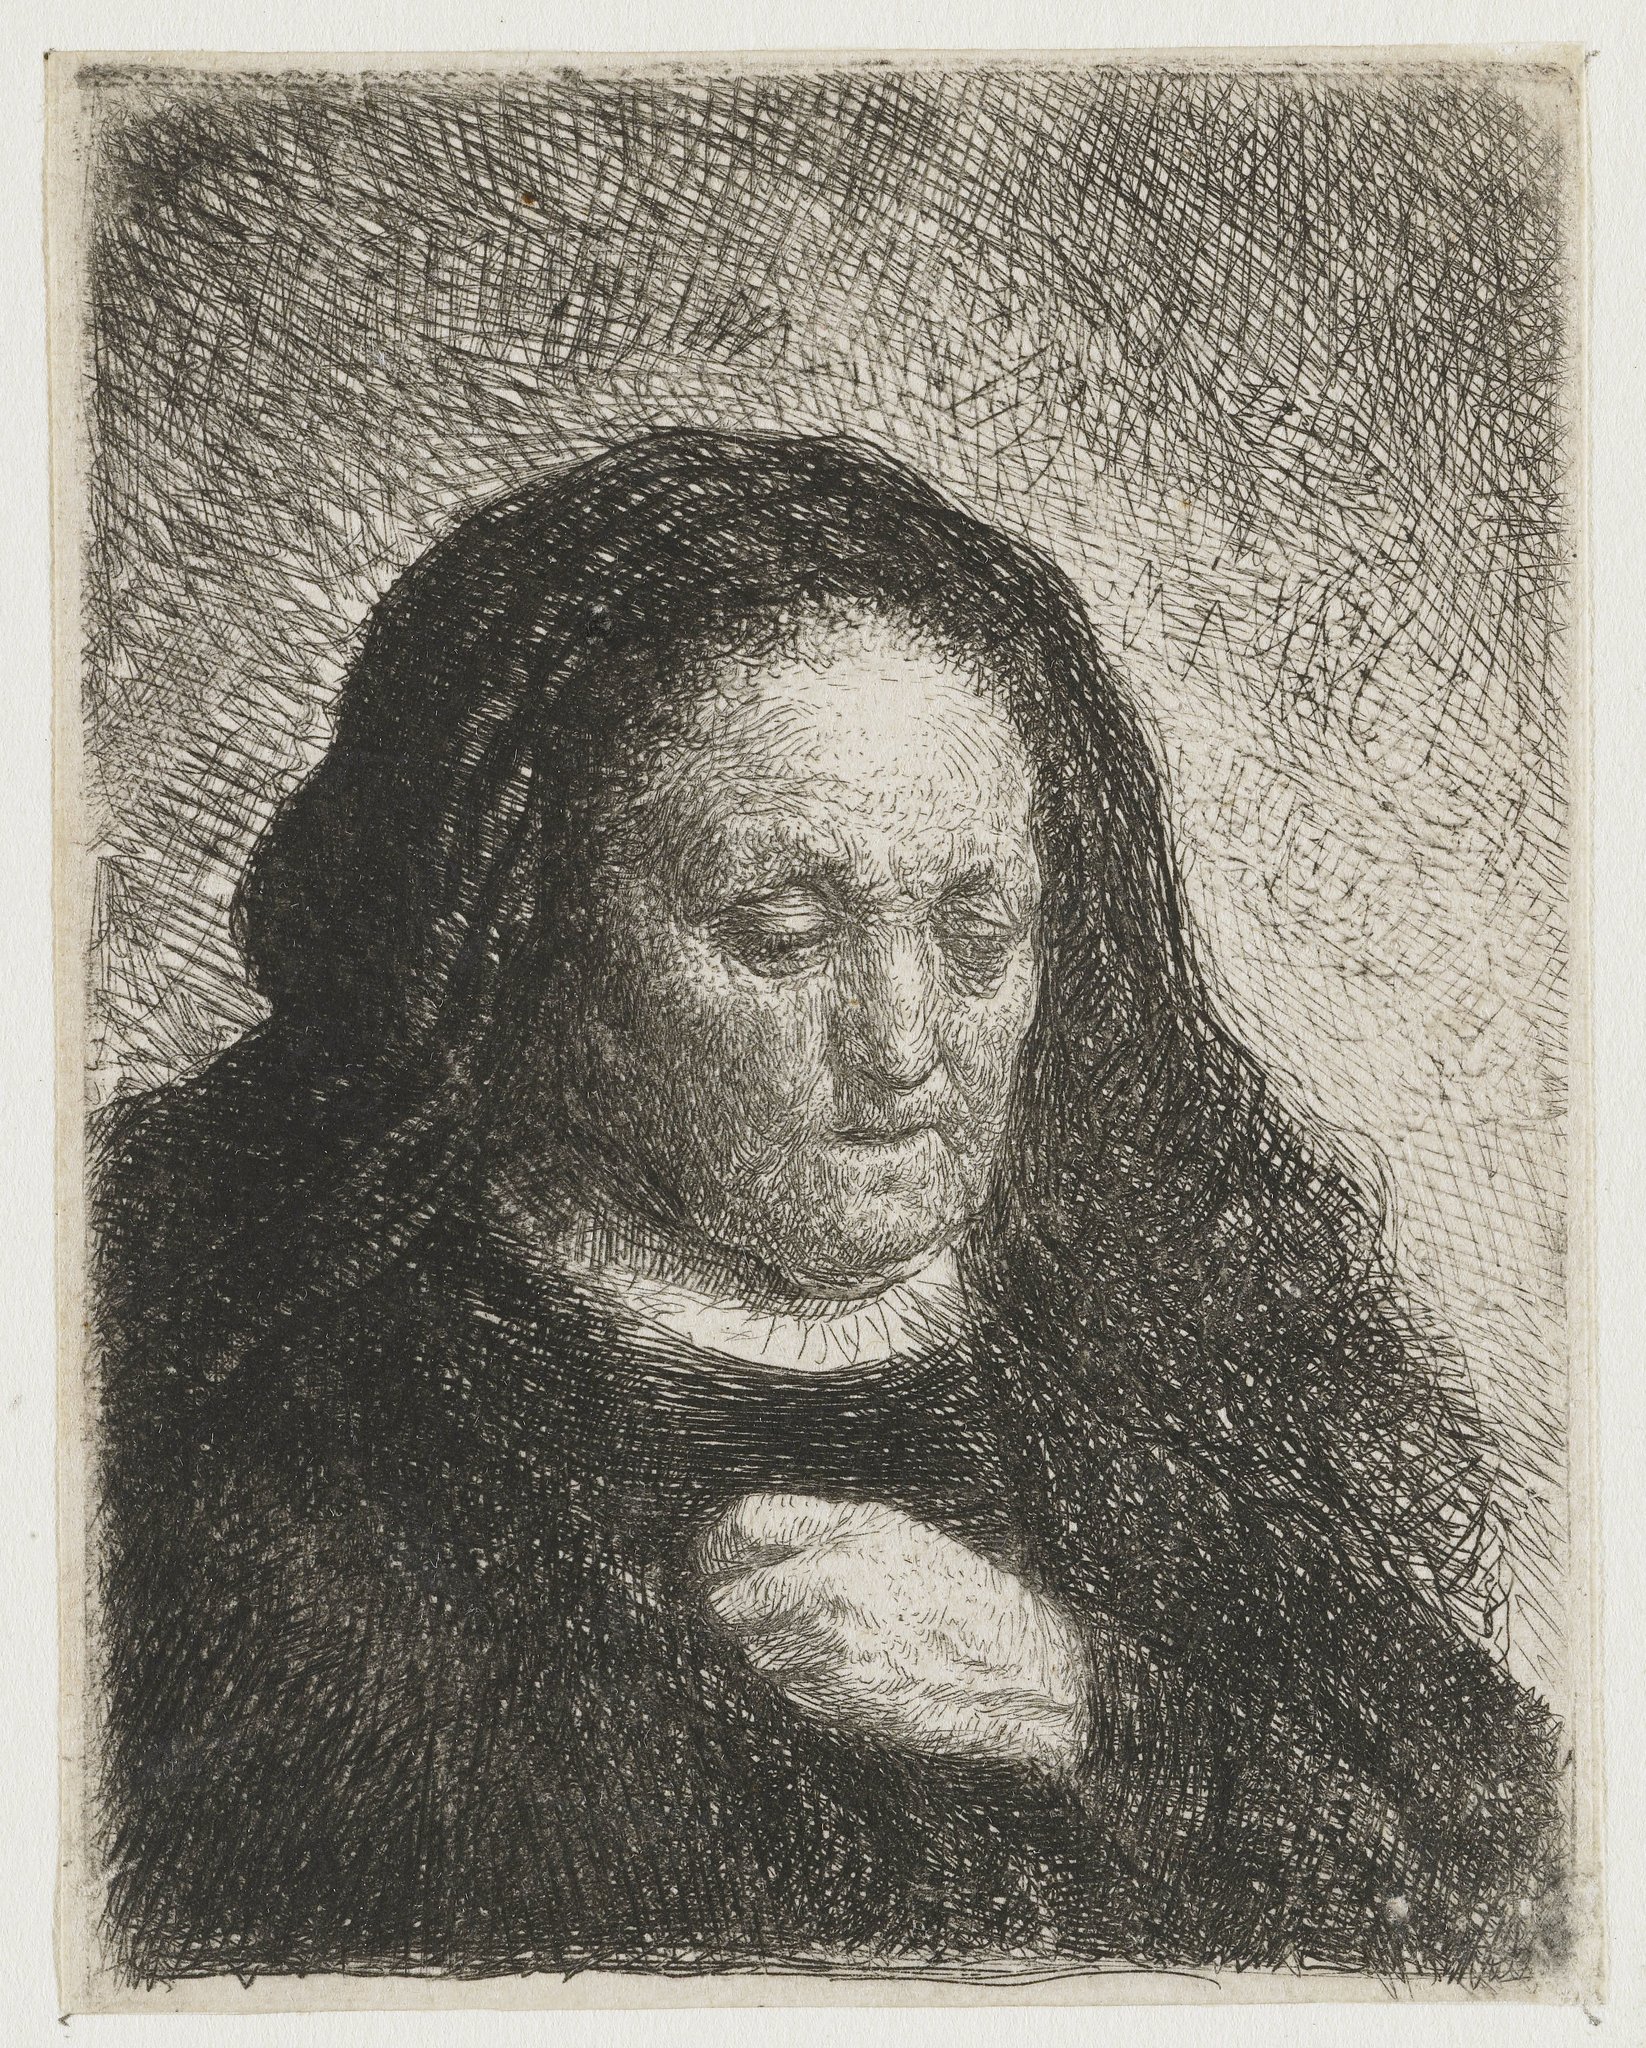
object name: print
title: The artist's mother with her hand on her chest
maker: rembrandt van rijn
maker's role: draughtsman, painter, print maker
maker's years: 1606-1669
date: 1631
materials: paper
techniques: etching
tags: neeltje willemsdr. zuytbrouck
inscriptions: collector's mark: Lugt 240